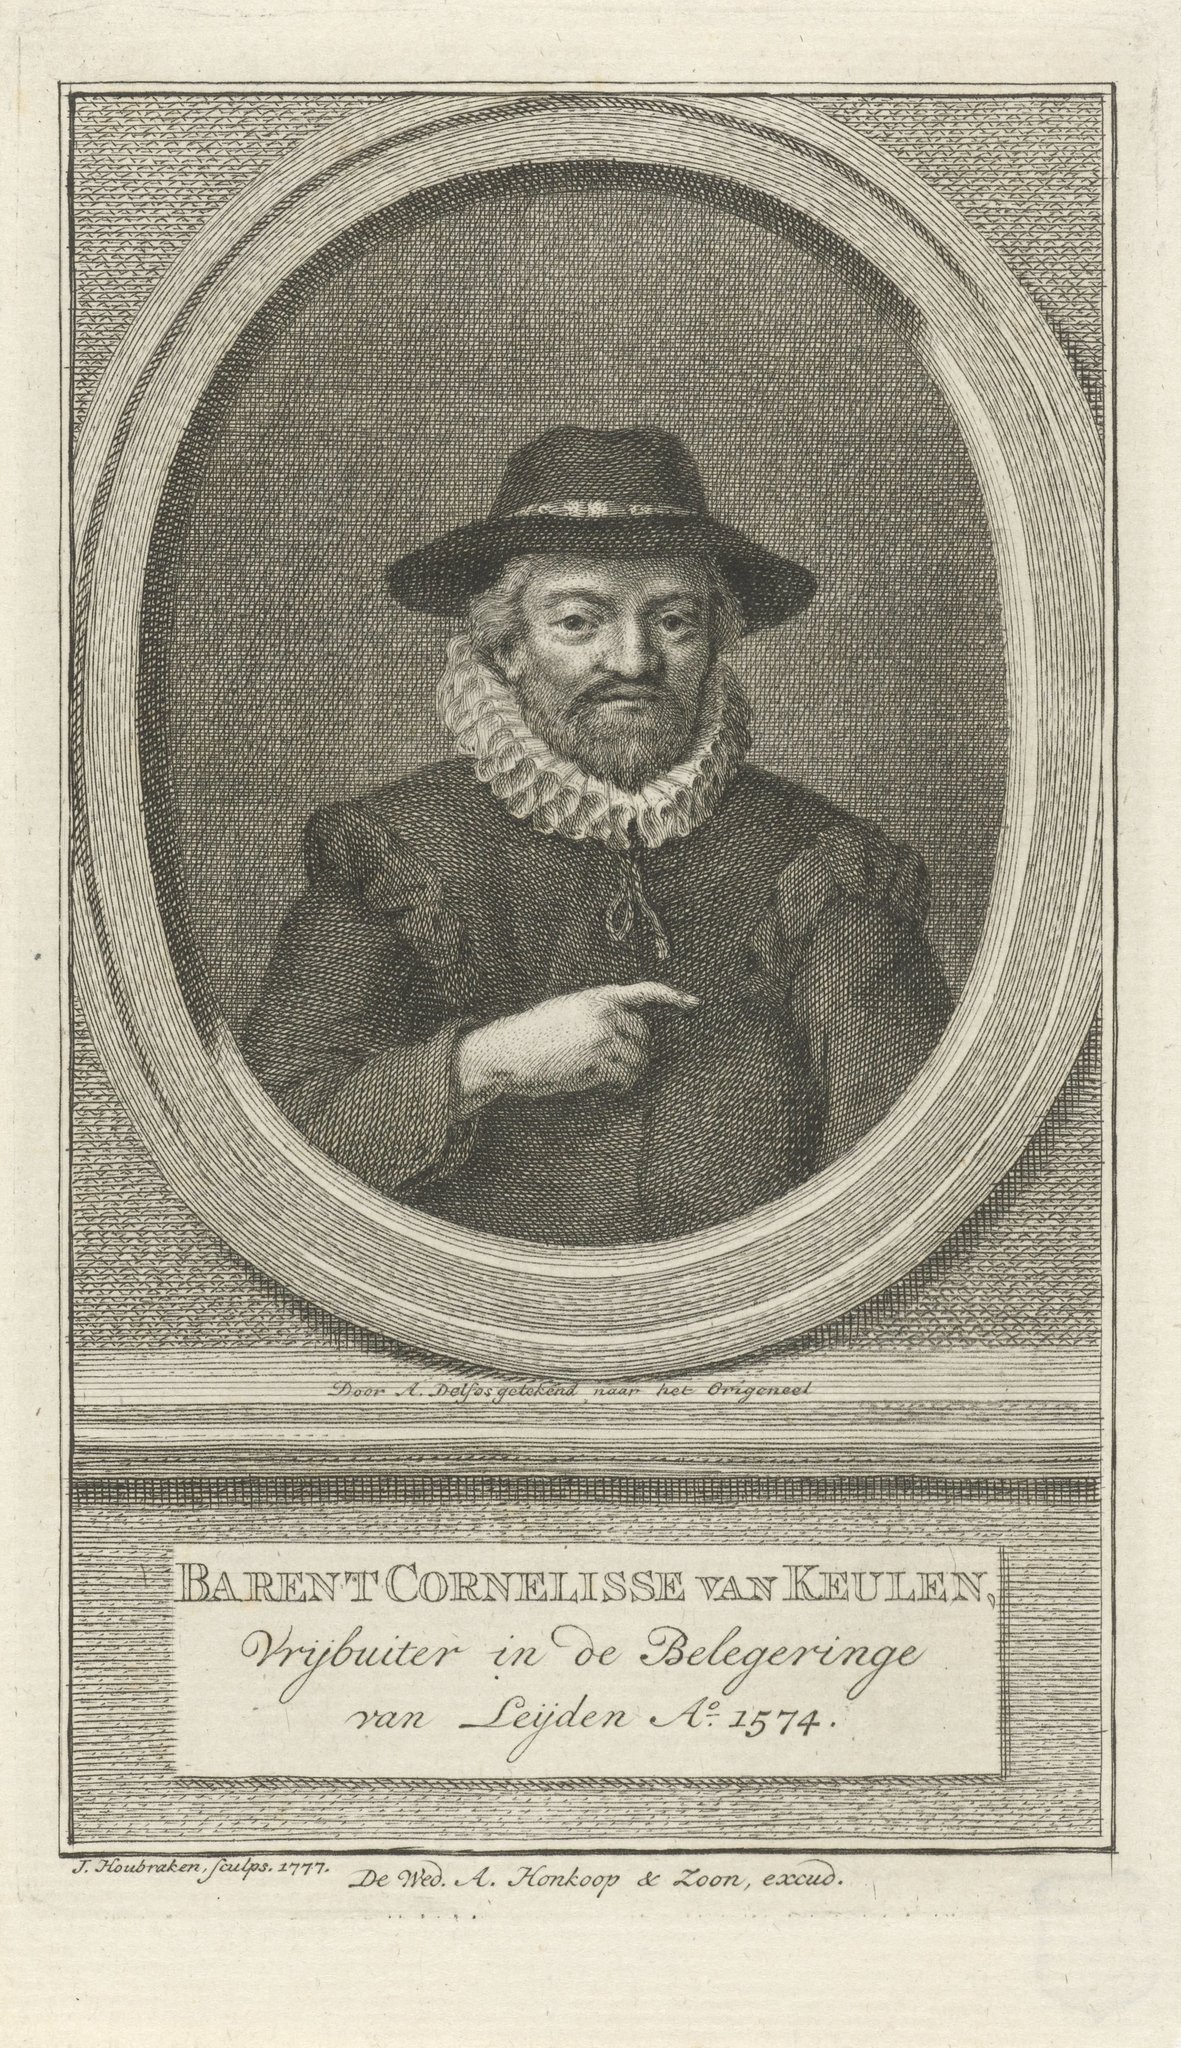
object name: print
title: Barent Cornelisse van Keulen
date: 1777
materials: paper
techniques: engraving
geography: amsterdam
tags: barend kornelisse van keulen, beleg van leiden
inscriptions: collector's mark: Lugt 2228, collector's mark: Lugt 963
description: Volgens Ver Huell prent ook gebruitk in: Adrianus Severinus, Oorspronckelijke beschrijving van de vermaerde belegering en 't ontzet der stad Leiden. Leiden: wed. A. Honkoop en zoon, vijfde editie, 1777.